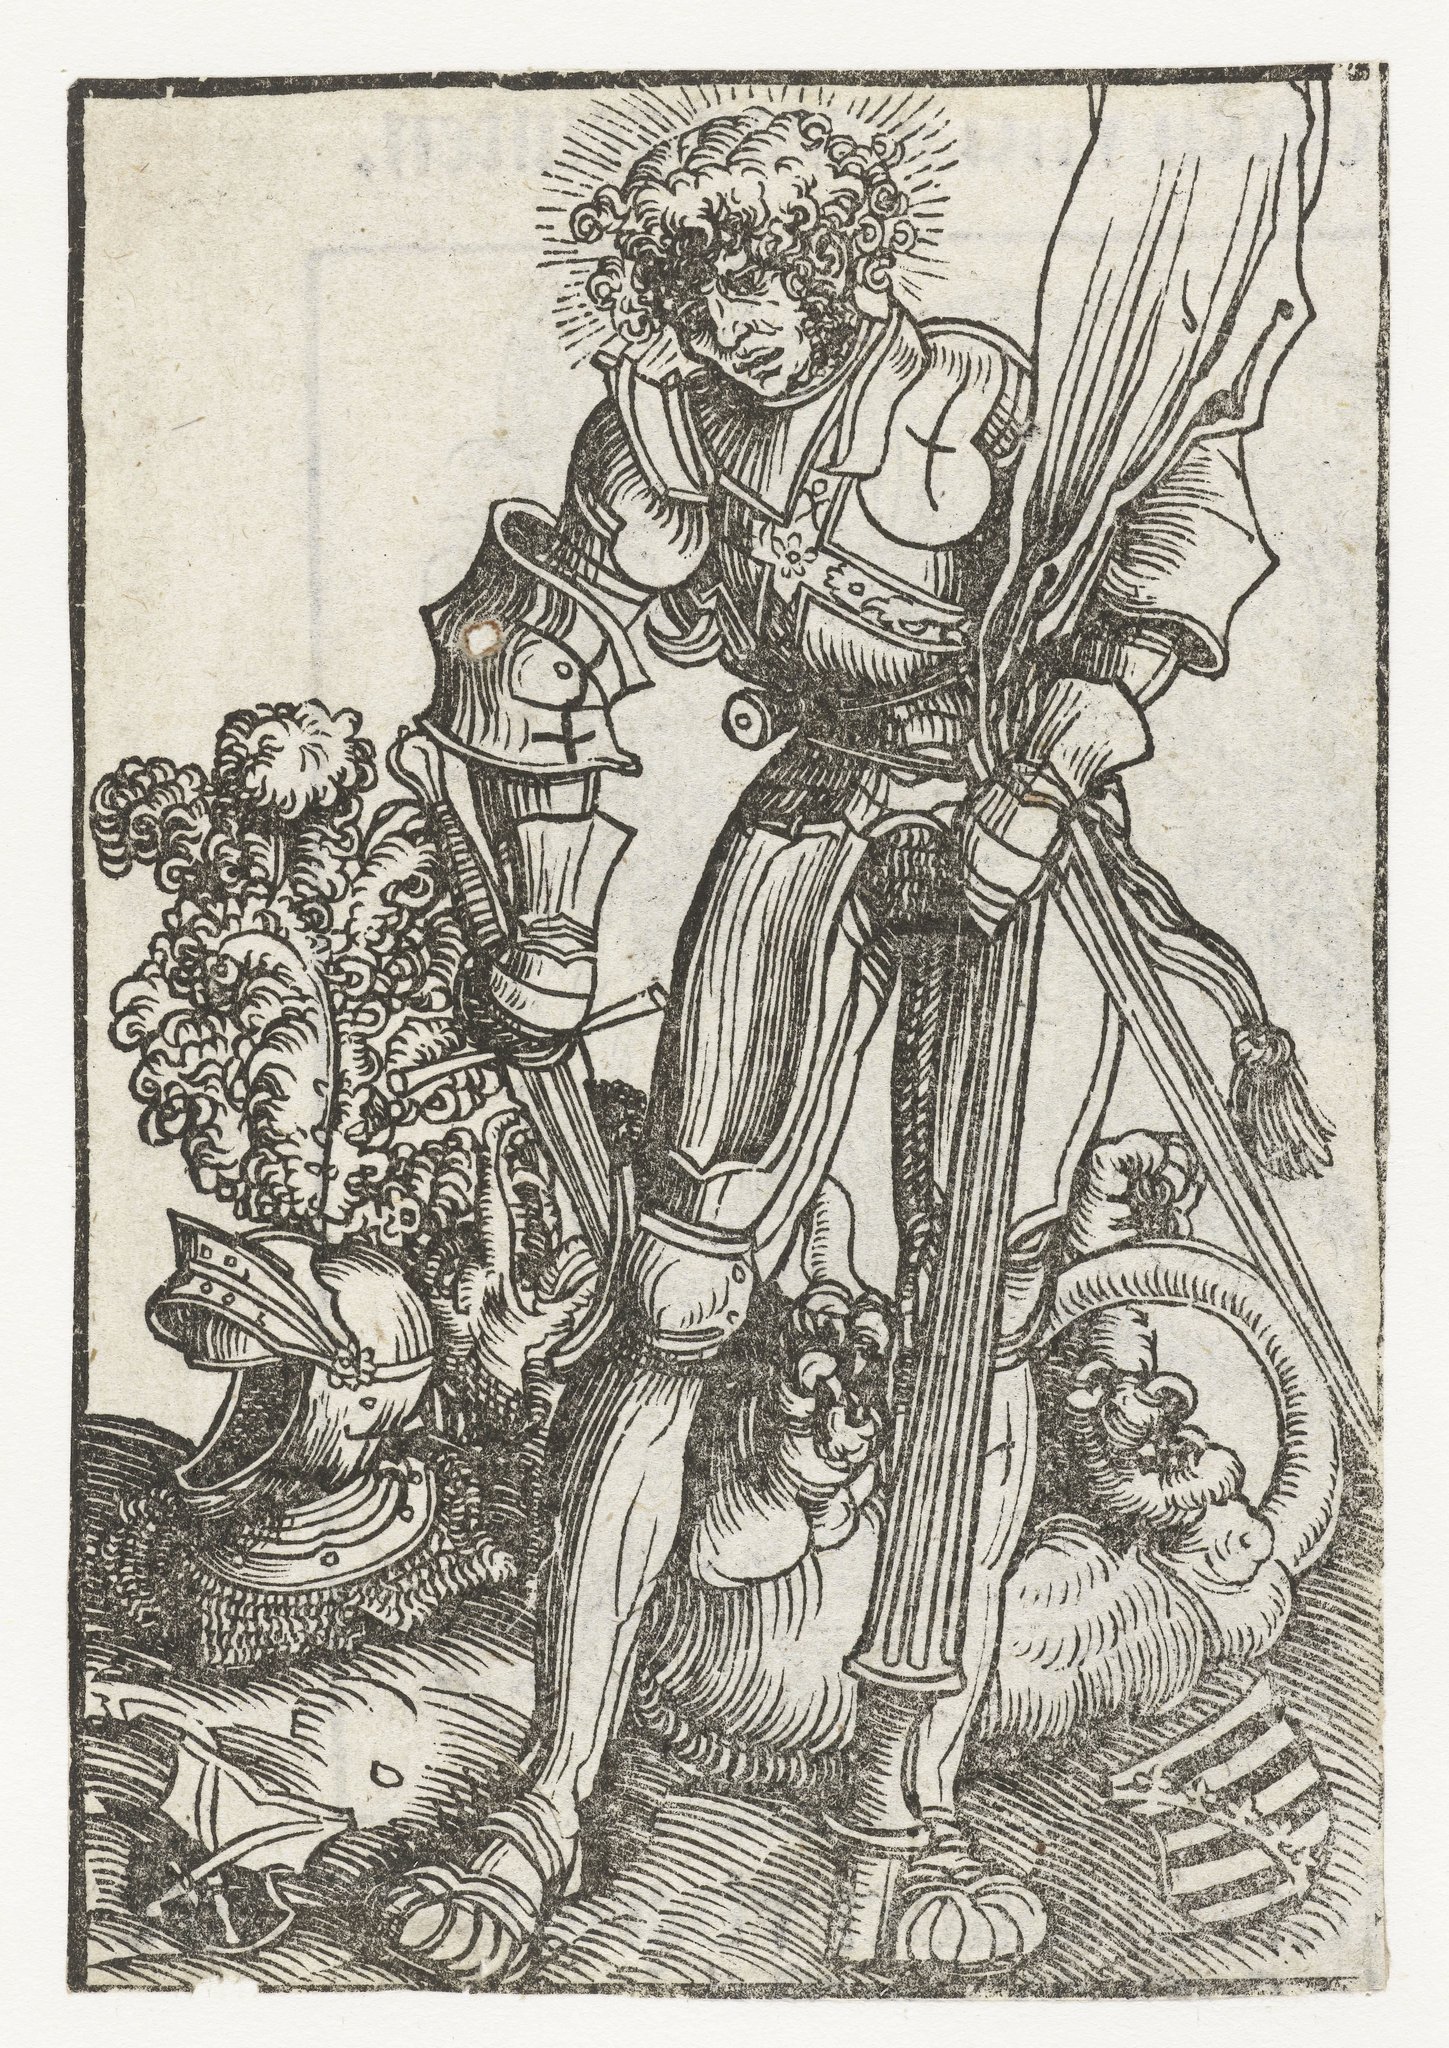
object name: book illustration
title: Beeld van Joris en de draak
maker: lucas cranach (i)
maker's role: draughtsman, print maker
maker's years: 1472-1553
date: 1509-1549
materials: paper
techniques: woodcut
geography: wittenberg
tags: the warrior martyr george (georgius); possible attributes: banner (red cross on white field), (red) cross, dragon, (white) horse, broken lance, shield (with cross), sword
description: De houtblokken werden in 1509 voor het eerst gebruikt in: Dye zaigung des hochlobwirdigen hailigthums der Stiftkirchen allerhailigen zu wittenburg, Wittenberg, Symphorian Reinhart. Daarna volgden verschillende uitgaven van de Hortulus Animae (uitgever Georg Rhau) waarin de blokken opnieuw gebruikt werden.